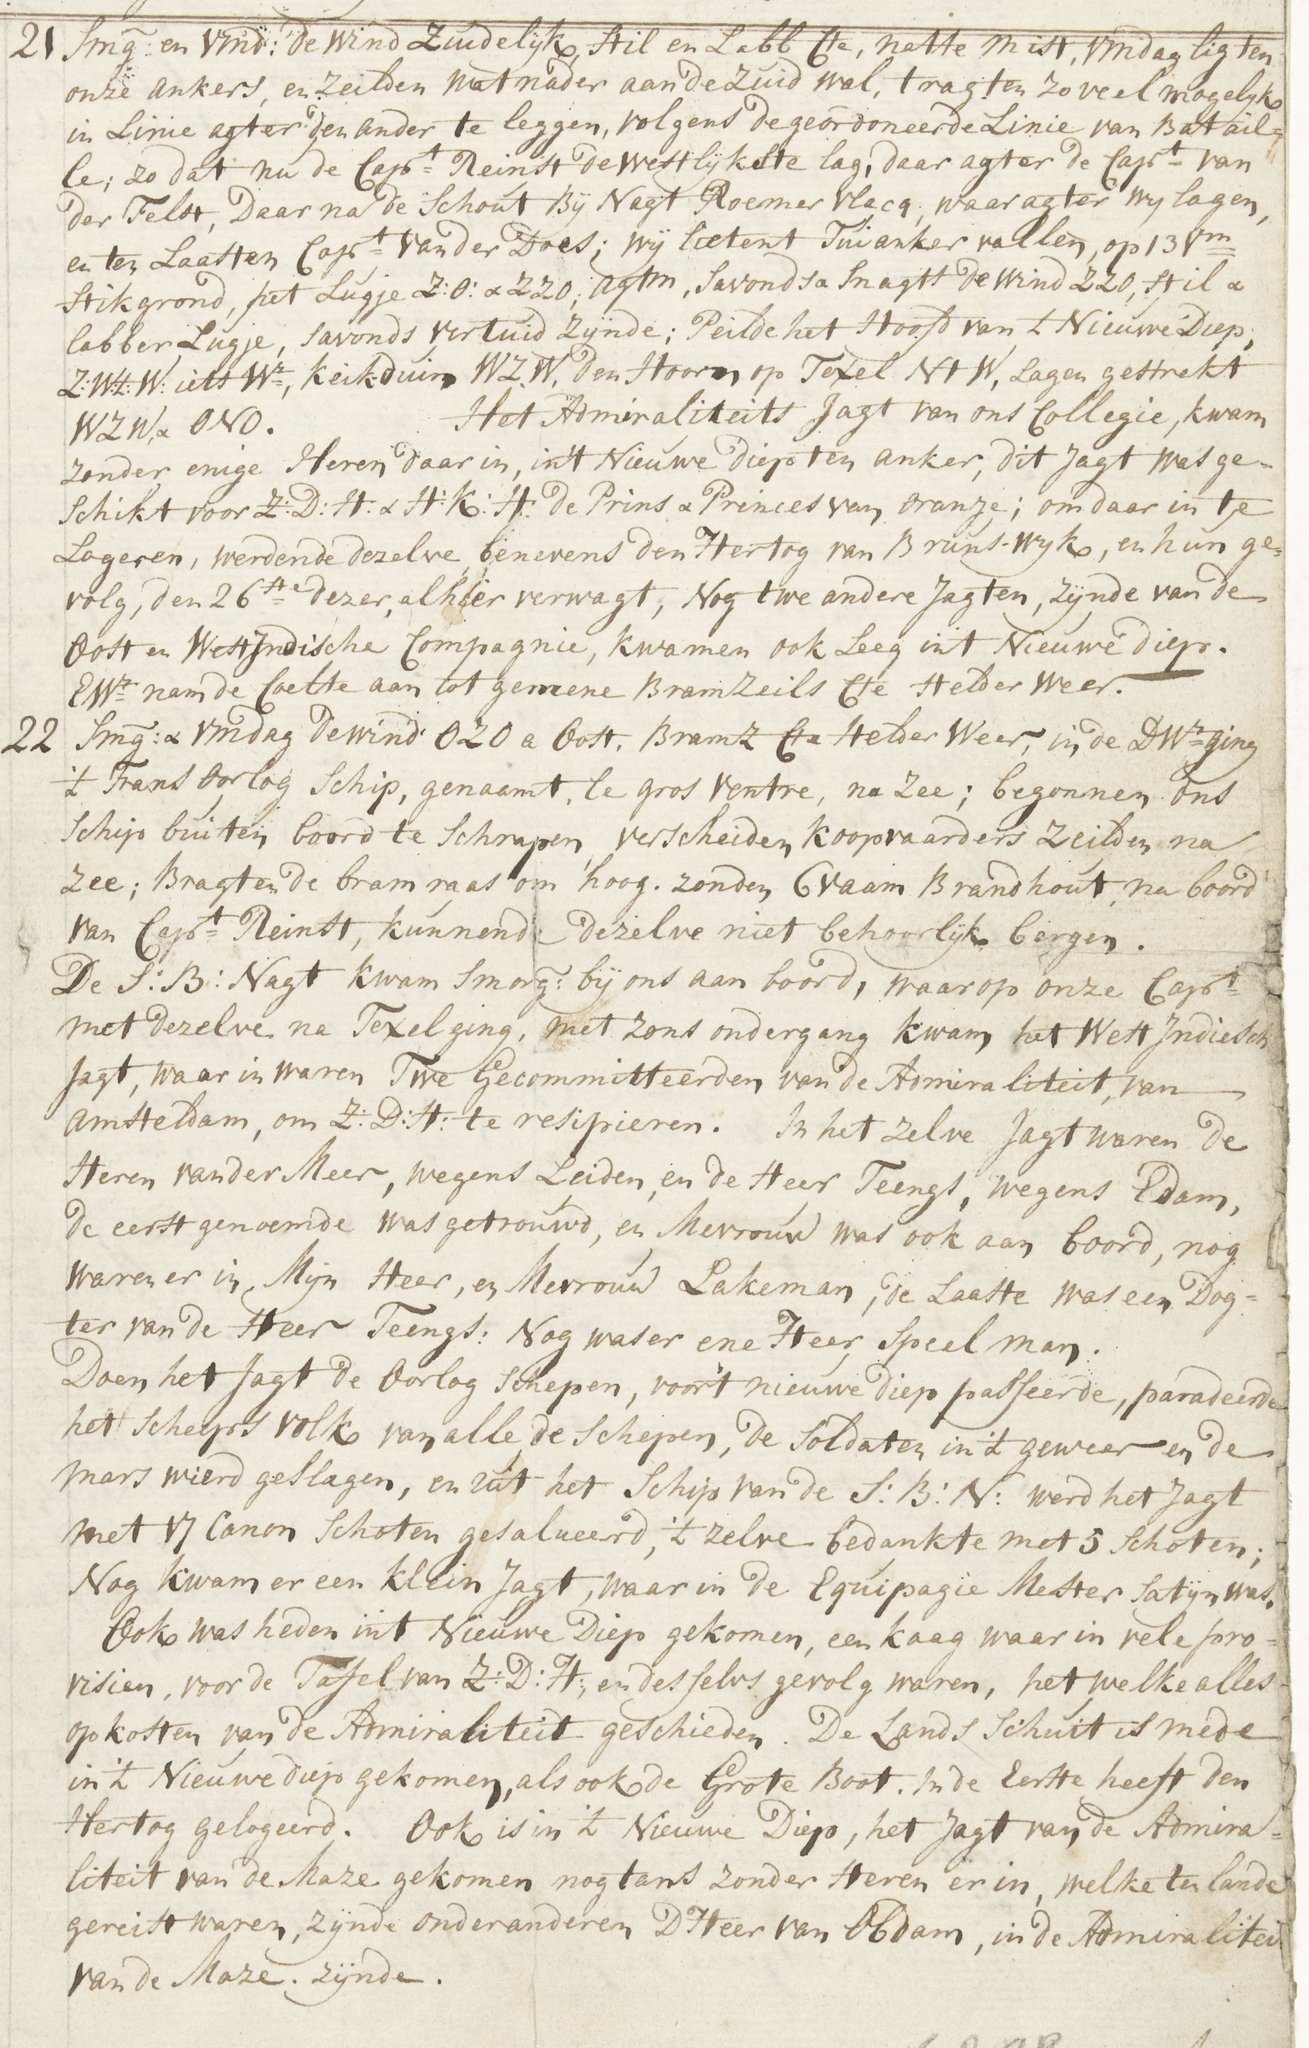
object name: manuscript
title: Verhaal van 't gene gepasseerd is, terwijl Z:D:H: en H:K:H de Prins en Princes van Oranje, (...) in Texel geweest zijn; In den Jare 1768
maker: Anonymous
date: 1705-1768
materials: paper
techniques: writing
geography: northern netherlands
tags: the hague, william v (prince of orange), painter, draughtsman, wilhelmina of prussia (princess of orange)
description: Handgeschreven verslag van het verblijf van prins Willem V en prinses Wilhelmina van Pruisen op Texel, 21-28 mei 1768. Vijf bladen aan beide zijden beschreven. Incompleet.